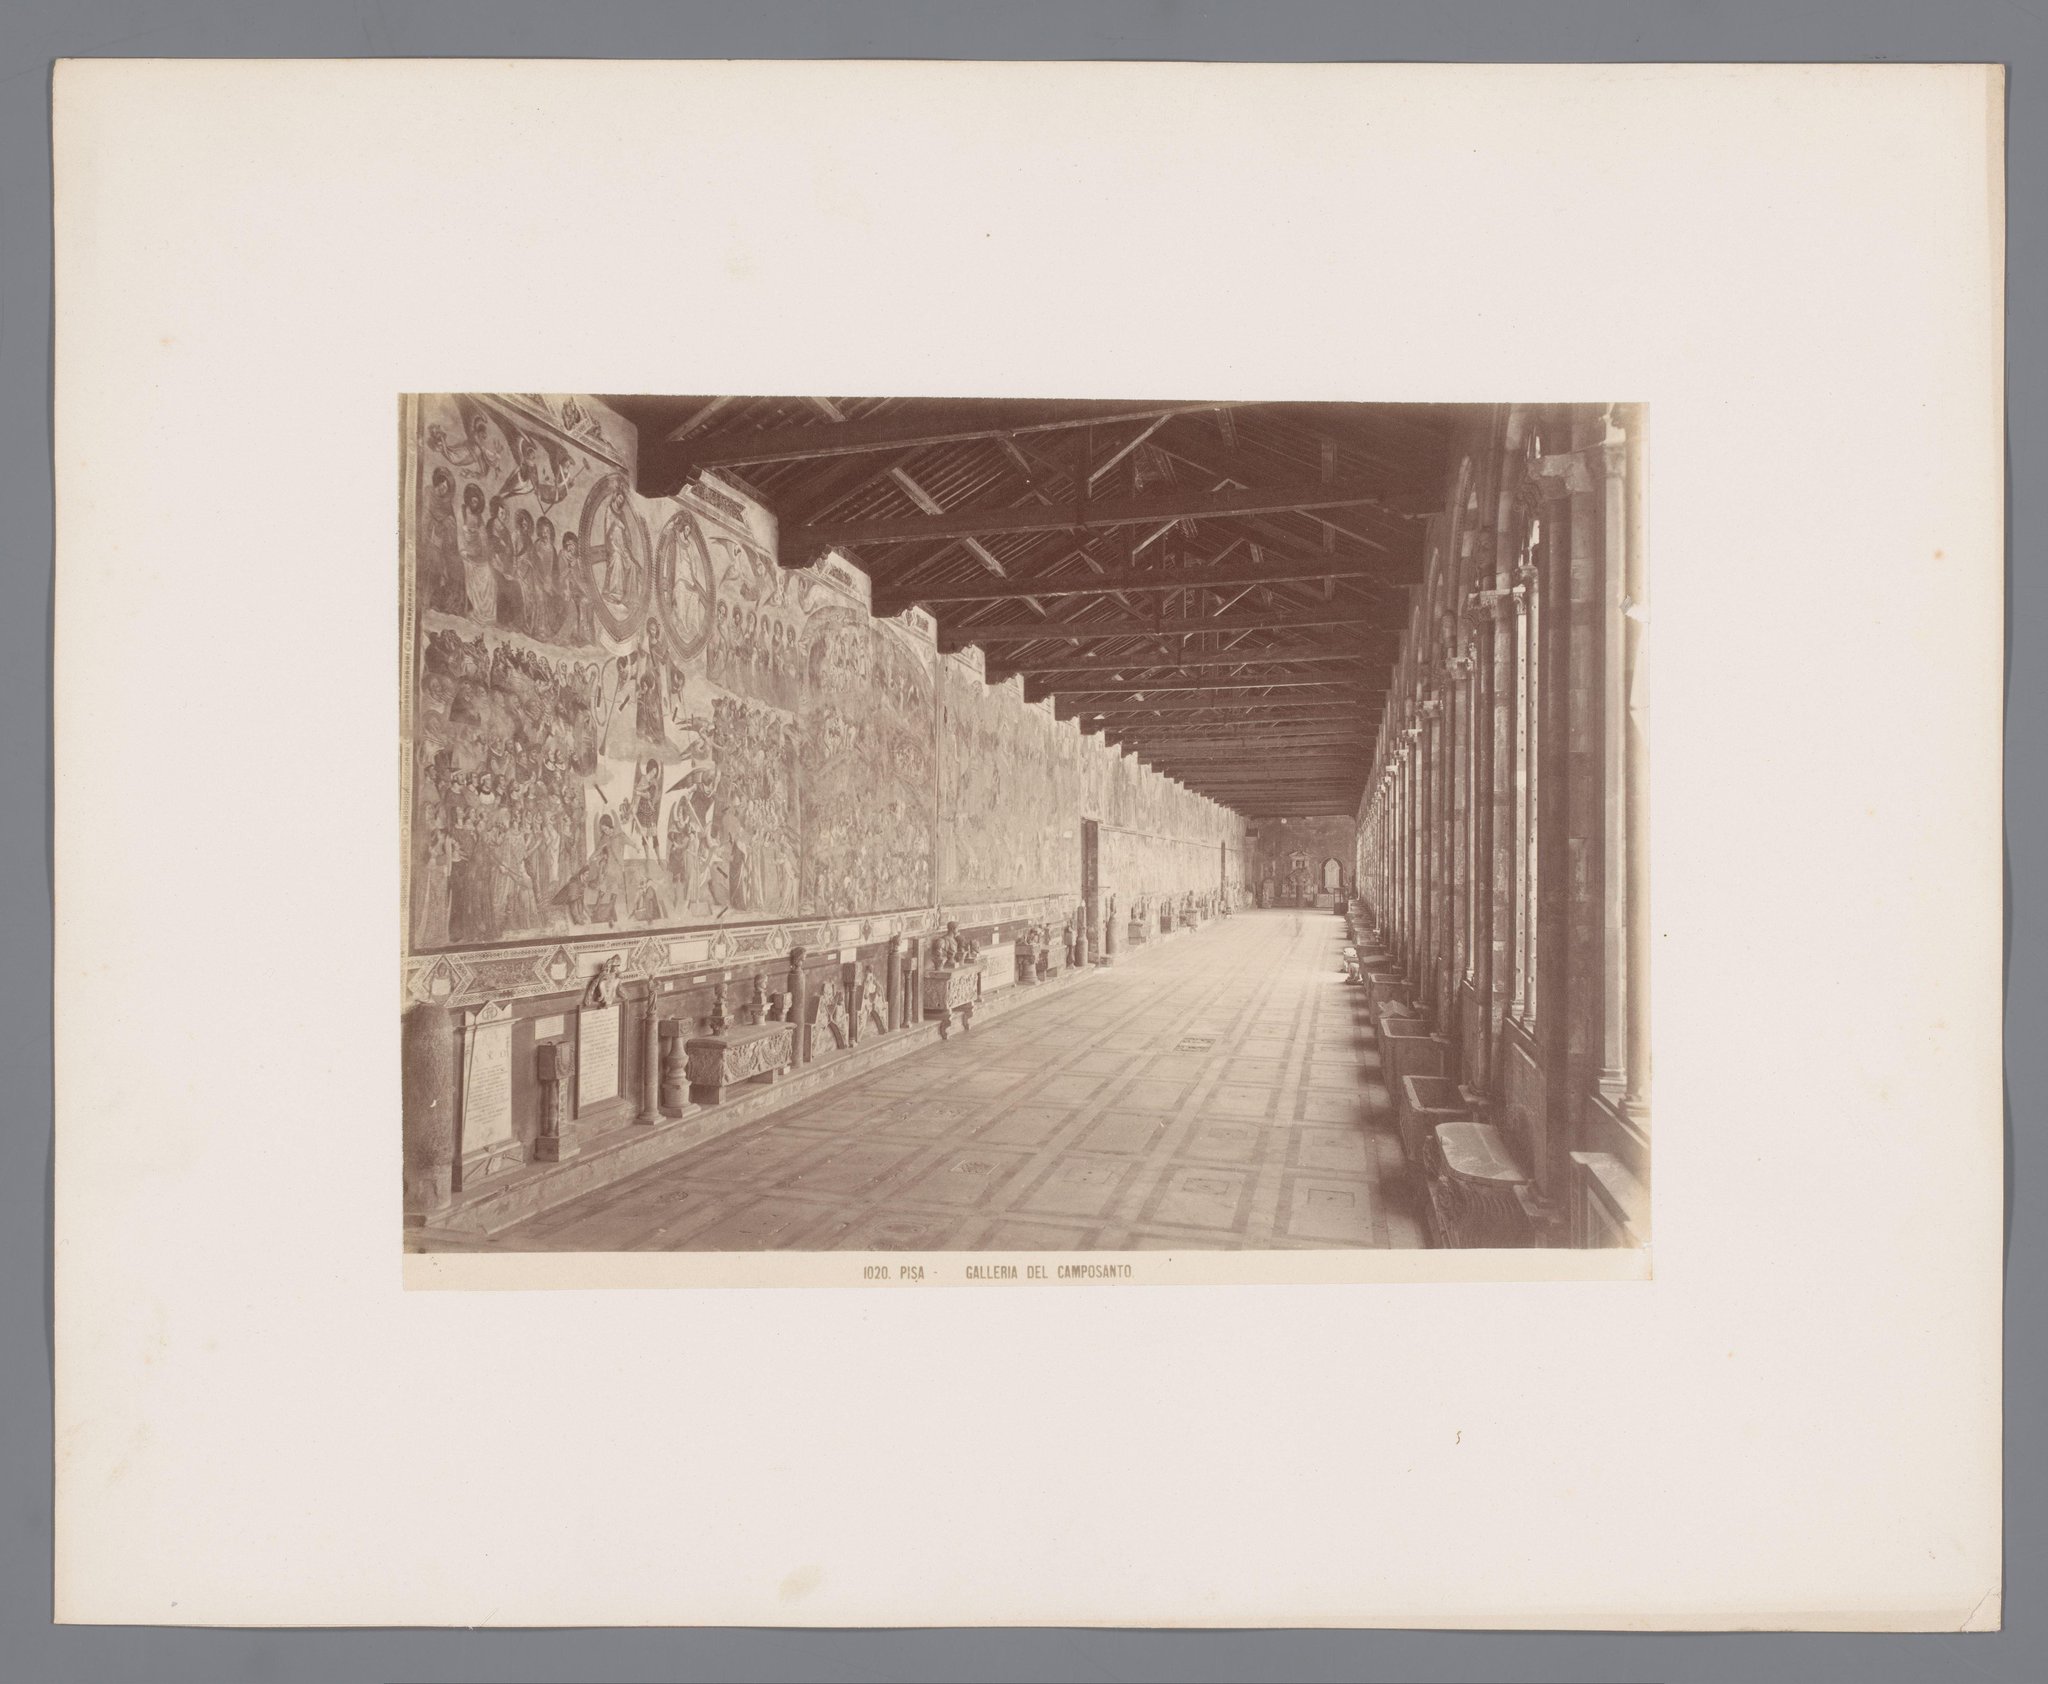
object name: photograph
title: Pisa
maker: Anonymous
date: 1851-1900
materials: cardboard, paper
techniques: albumen print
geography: pisa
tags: gallery (spacious corridor), wall-covering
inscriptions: number: ‘1020.’